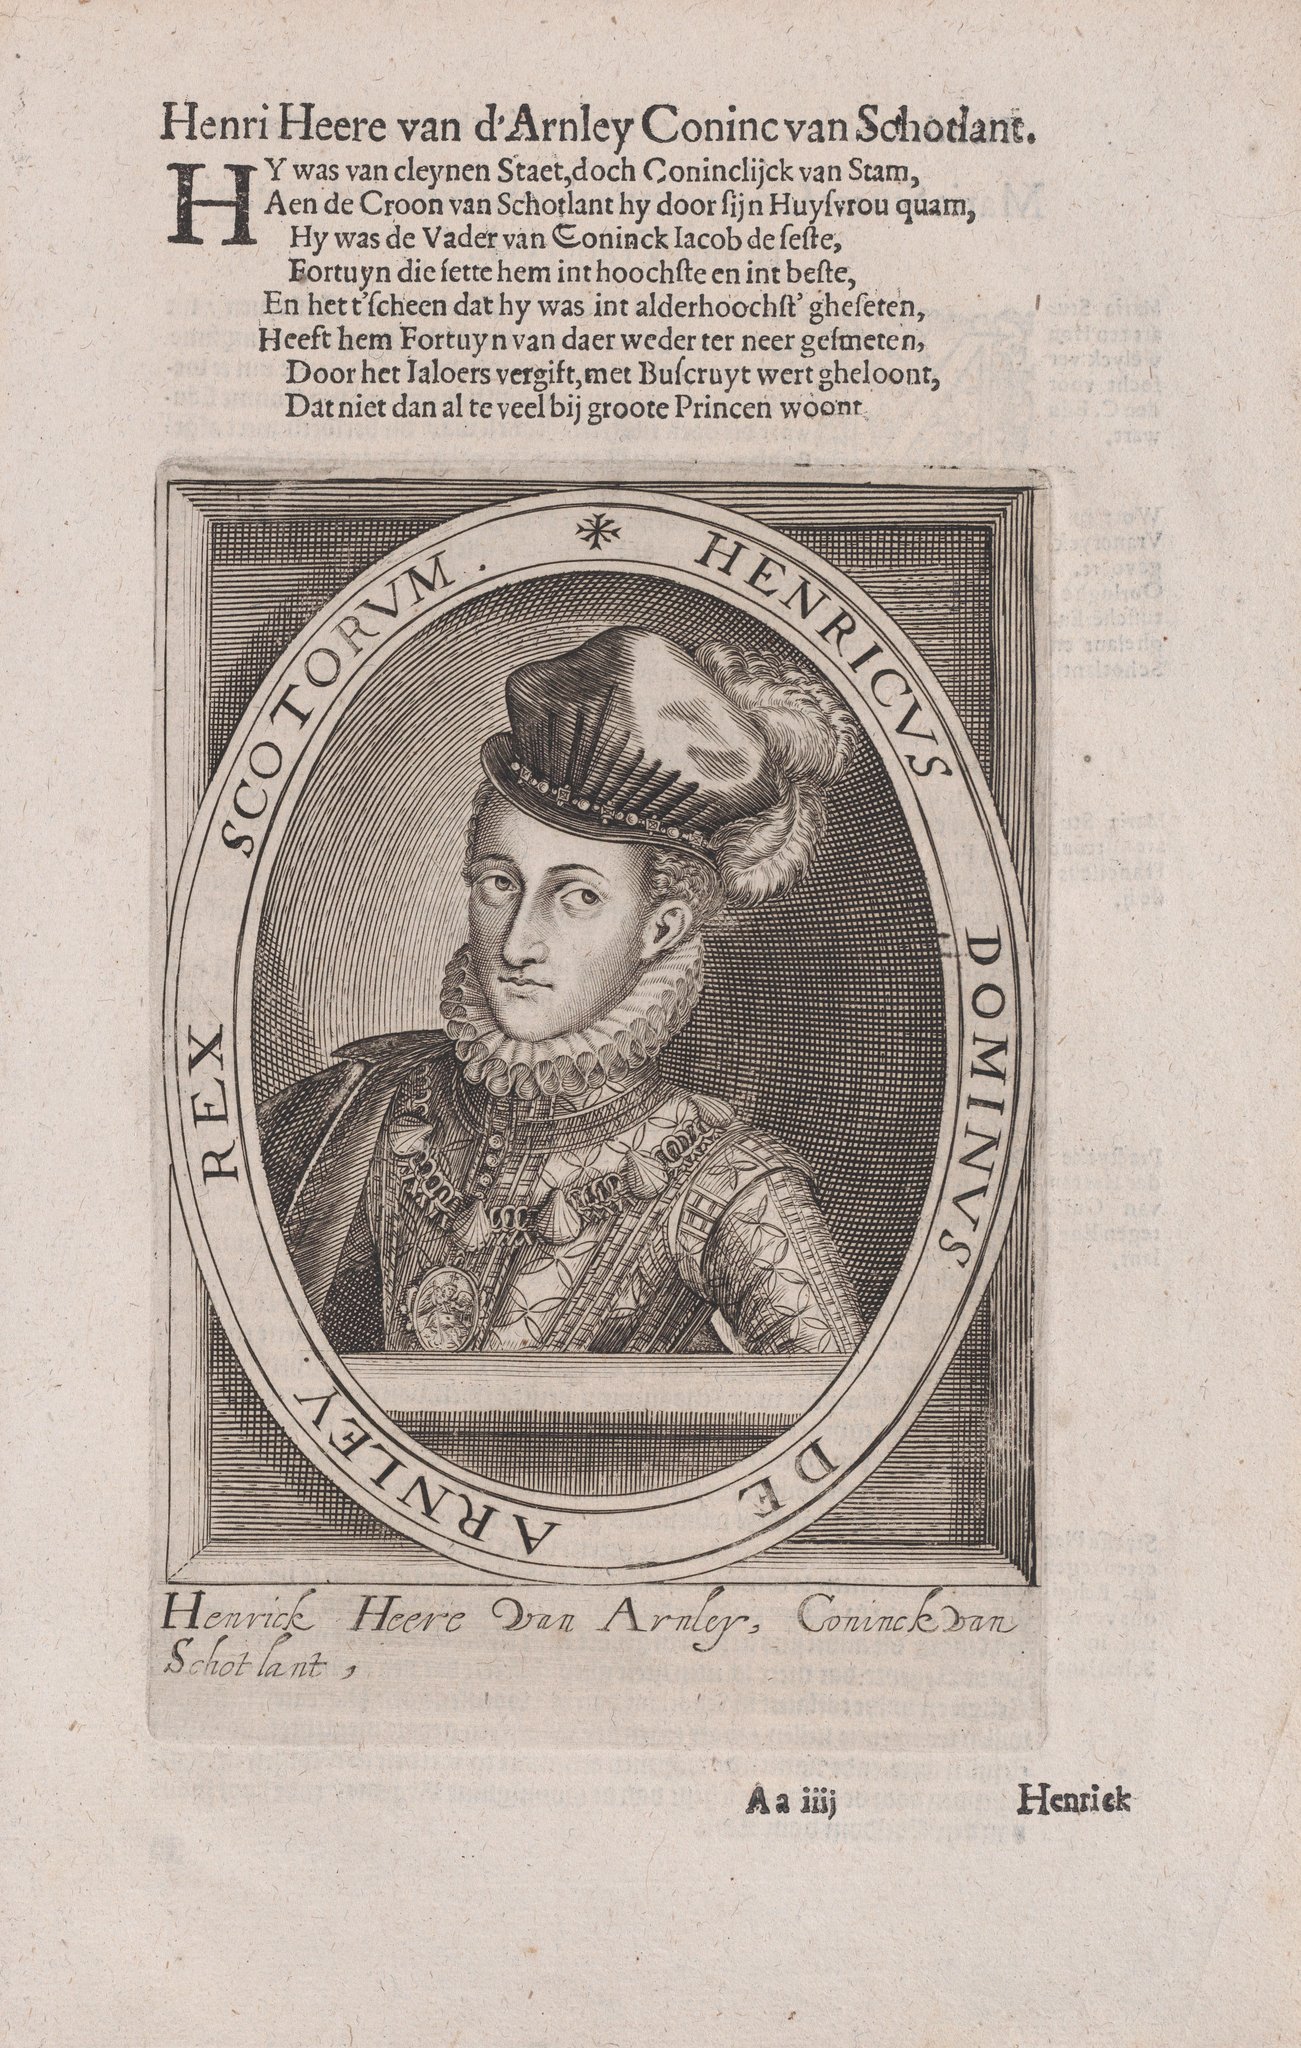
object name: print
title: Henry Stewart, Lord Darnley and Duke of Albany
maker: henry stuart, lord darnley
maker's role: sitter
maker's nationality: british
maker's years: 1545-1567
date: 1601-1700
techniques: engraving